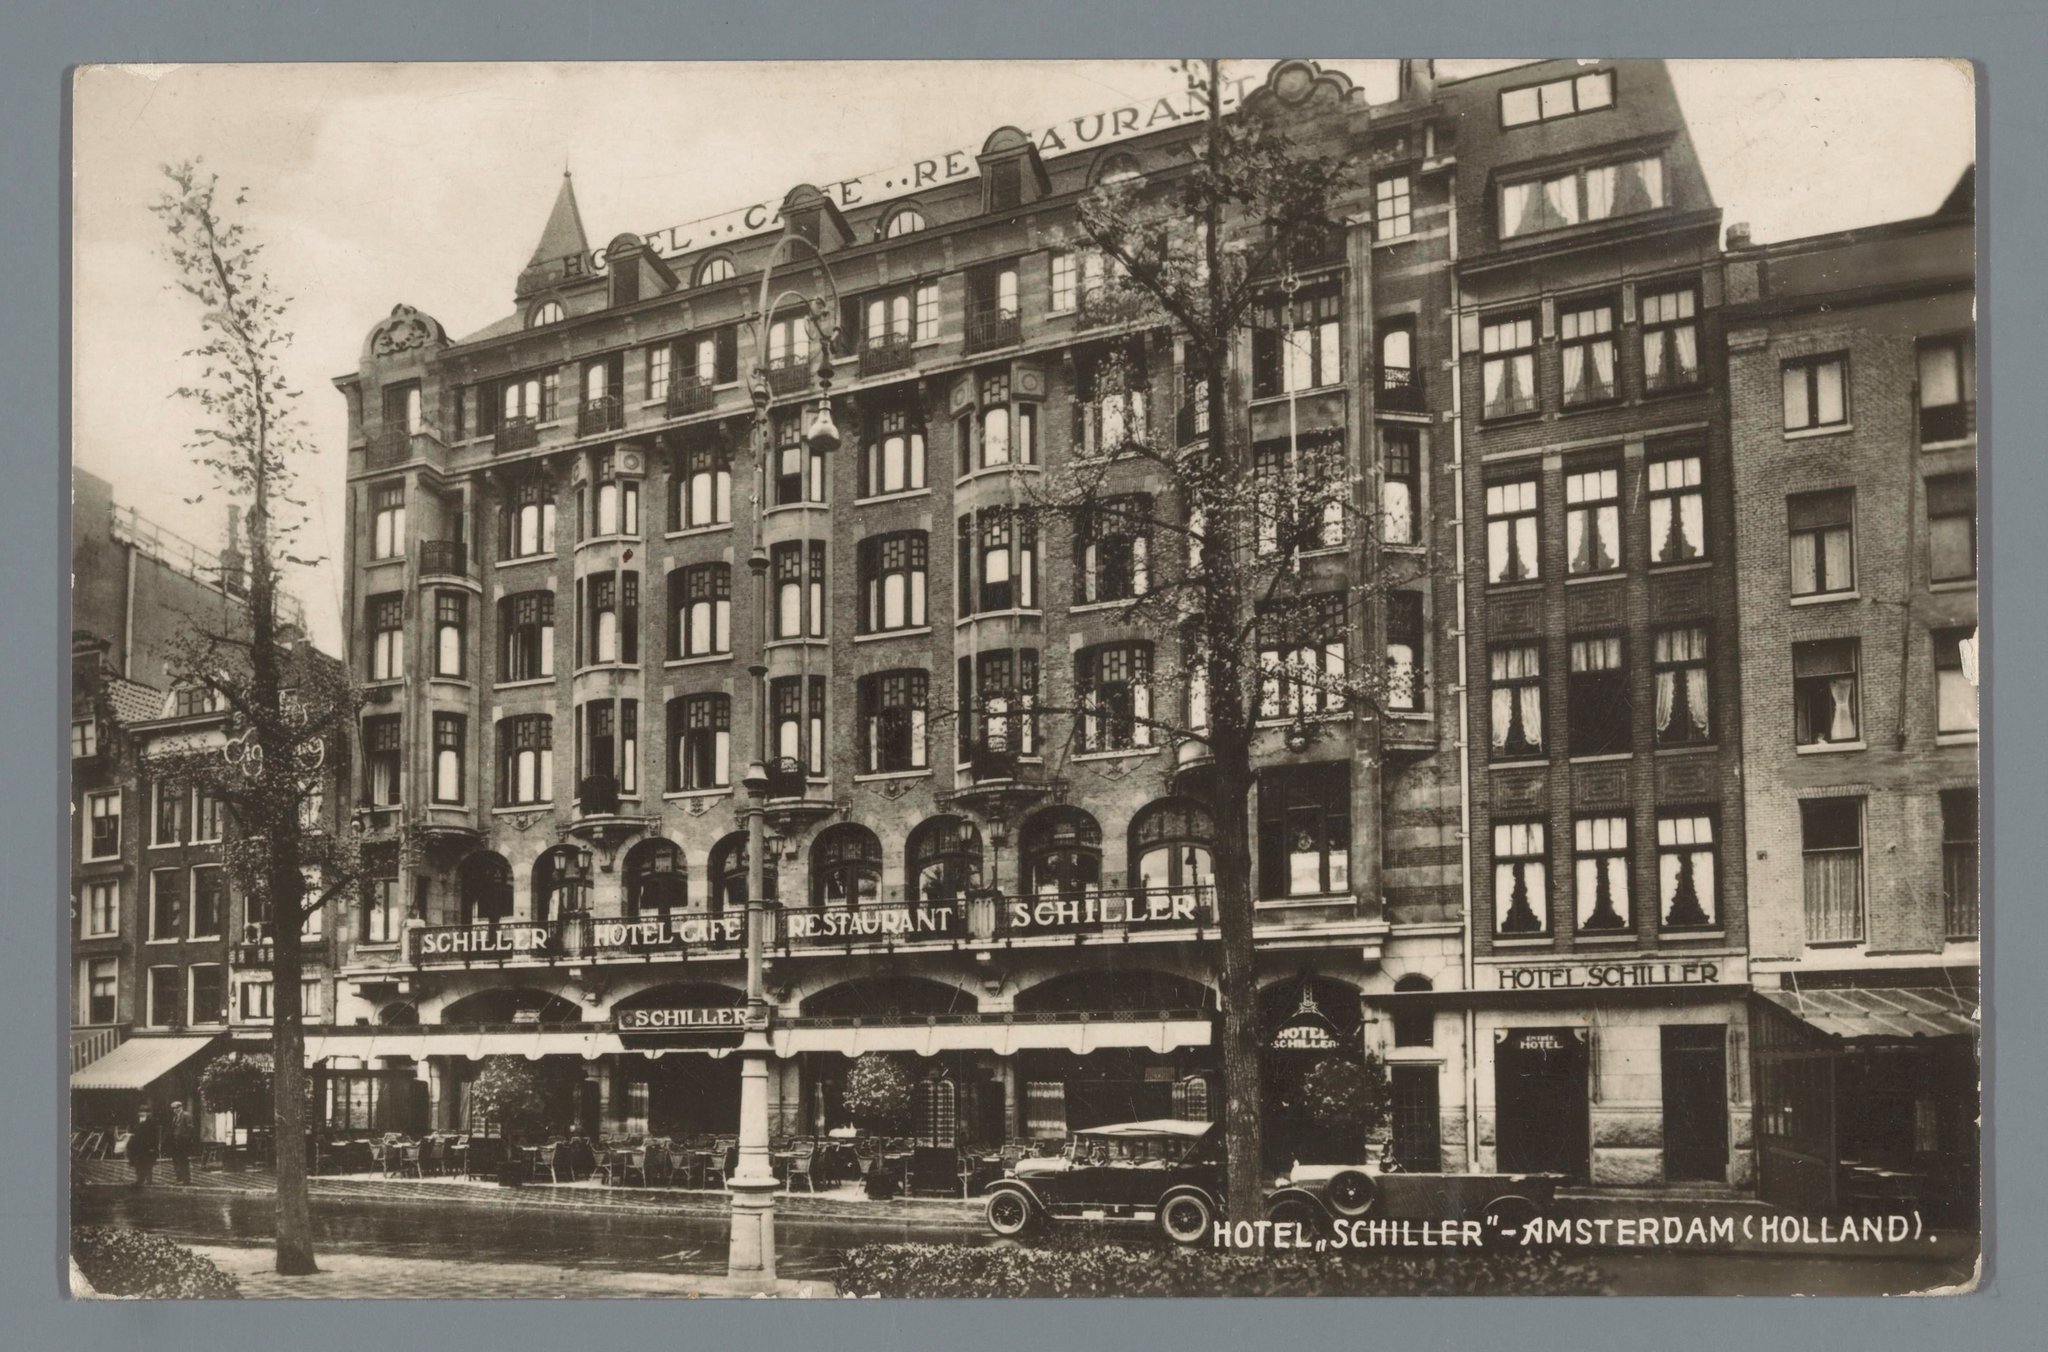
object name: photograph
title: Hotel "Schiller" - Amsterdam (Holland)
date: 1915-1930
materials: photographic support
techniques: gelatin silver print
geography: amsterdam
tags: hotel, hostelry, inn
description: Hotel Schiller aan het Rembrandtplein te Amsterdam.